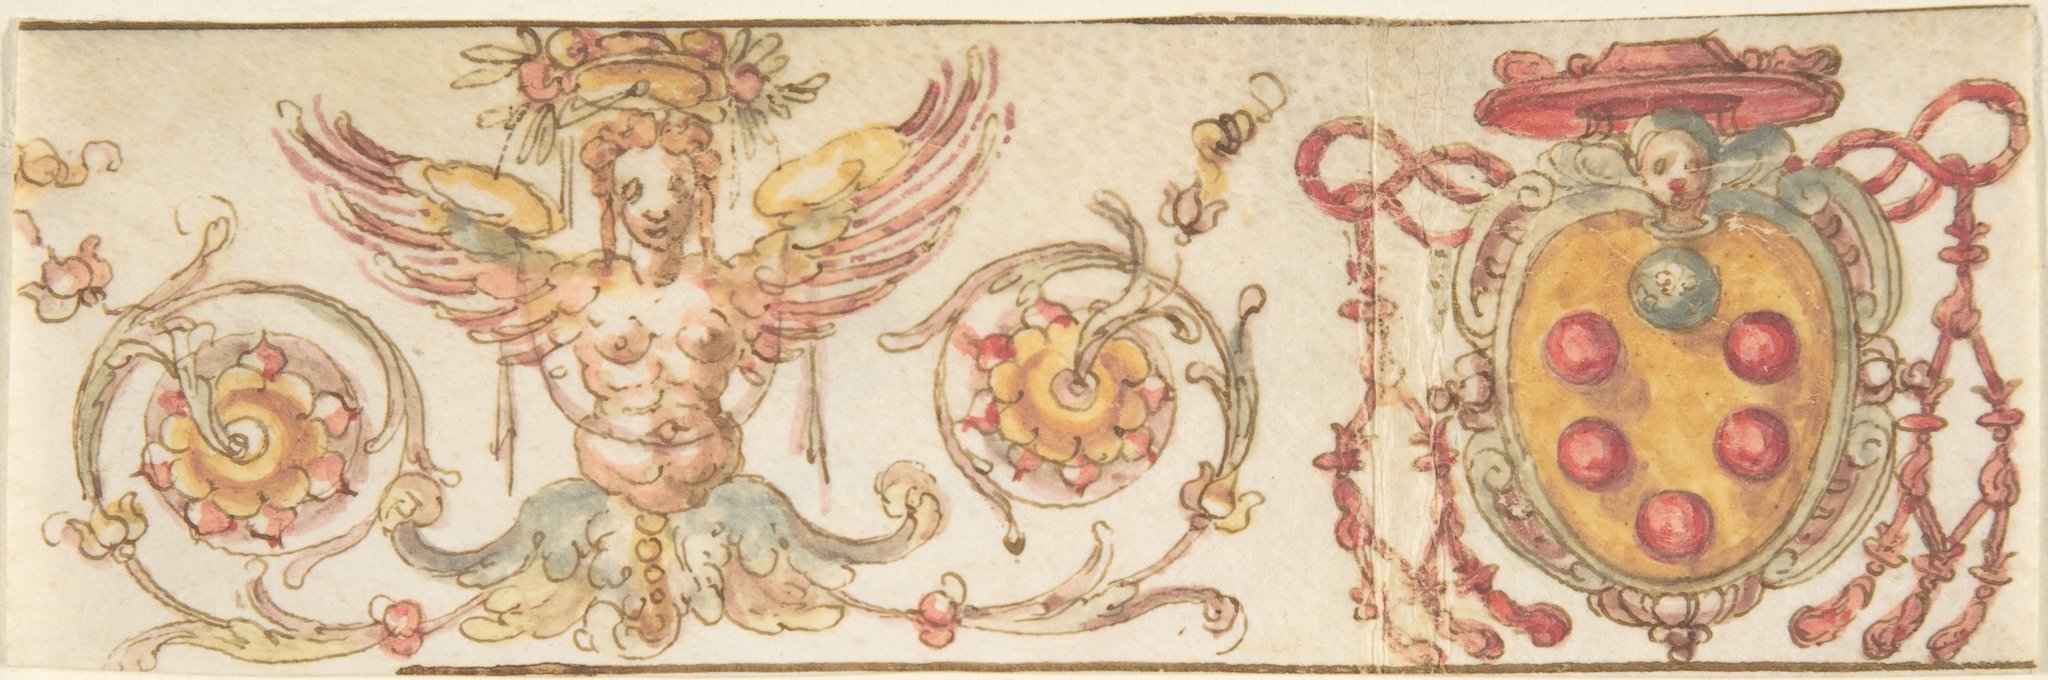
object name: drawing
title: Design with Medici Coat of Arms and Harpy (Embroidery Design?)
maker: anonymous, italian, 16th century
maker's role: artist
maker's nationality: italian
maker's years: 1500-1600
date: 1501-1600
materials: ink, parchment, watercolor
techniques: pen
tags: flowers,coat of arms